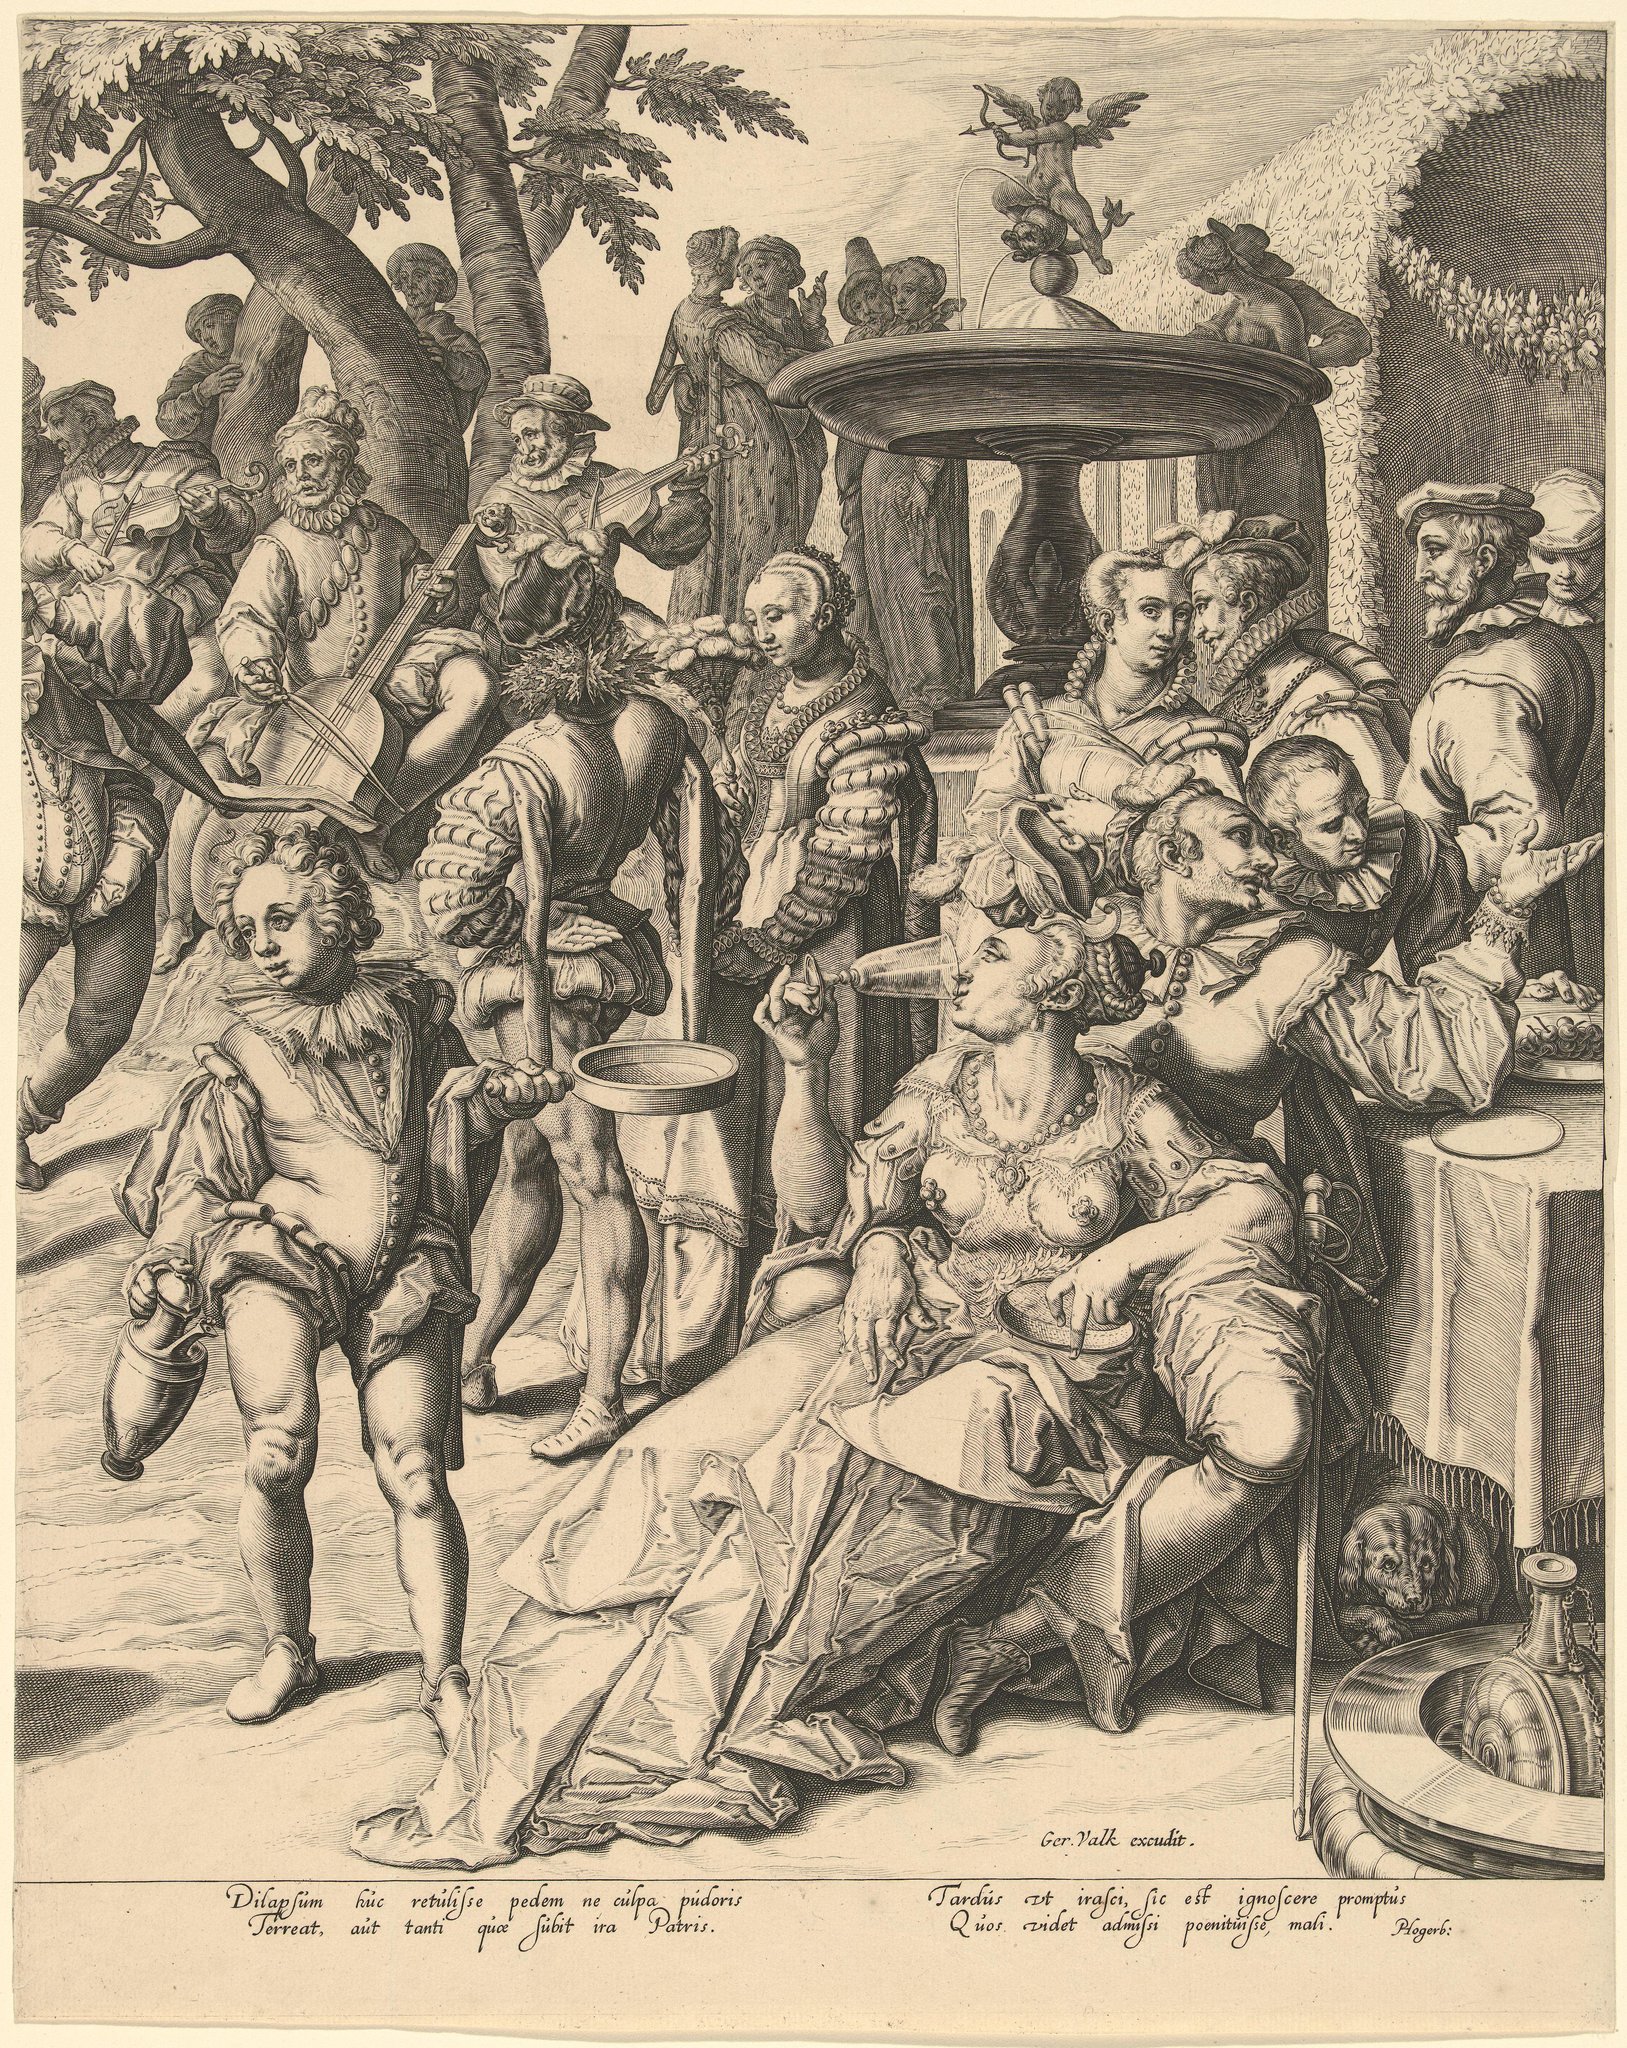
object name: print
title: De verloren zoon (rechterblad)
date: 1596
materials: paper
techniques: engraving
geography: leiden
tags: the parable of the prodigal son (luke 15:11-32)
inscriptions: collector's mark: Lugt 2228a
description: Rechterdeel van een voorstelling op twee bladen van een gezelschap dat zich in de buitenlucht bij een fontein vermaakt met eten, drinken, muziek en vrijages. Onder de voorstelling de laatste vier regels van een achtregelig Latijns gedicht.